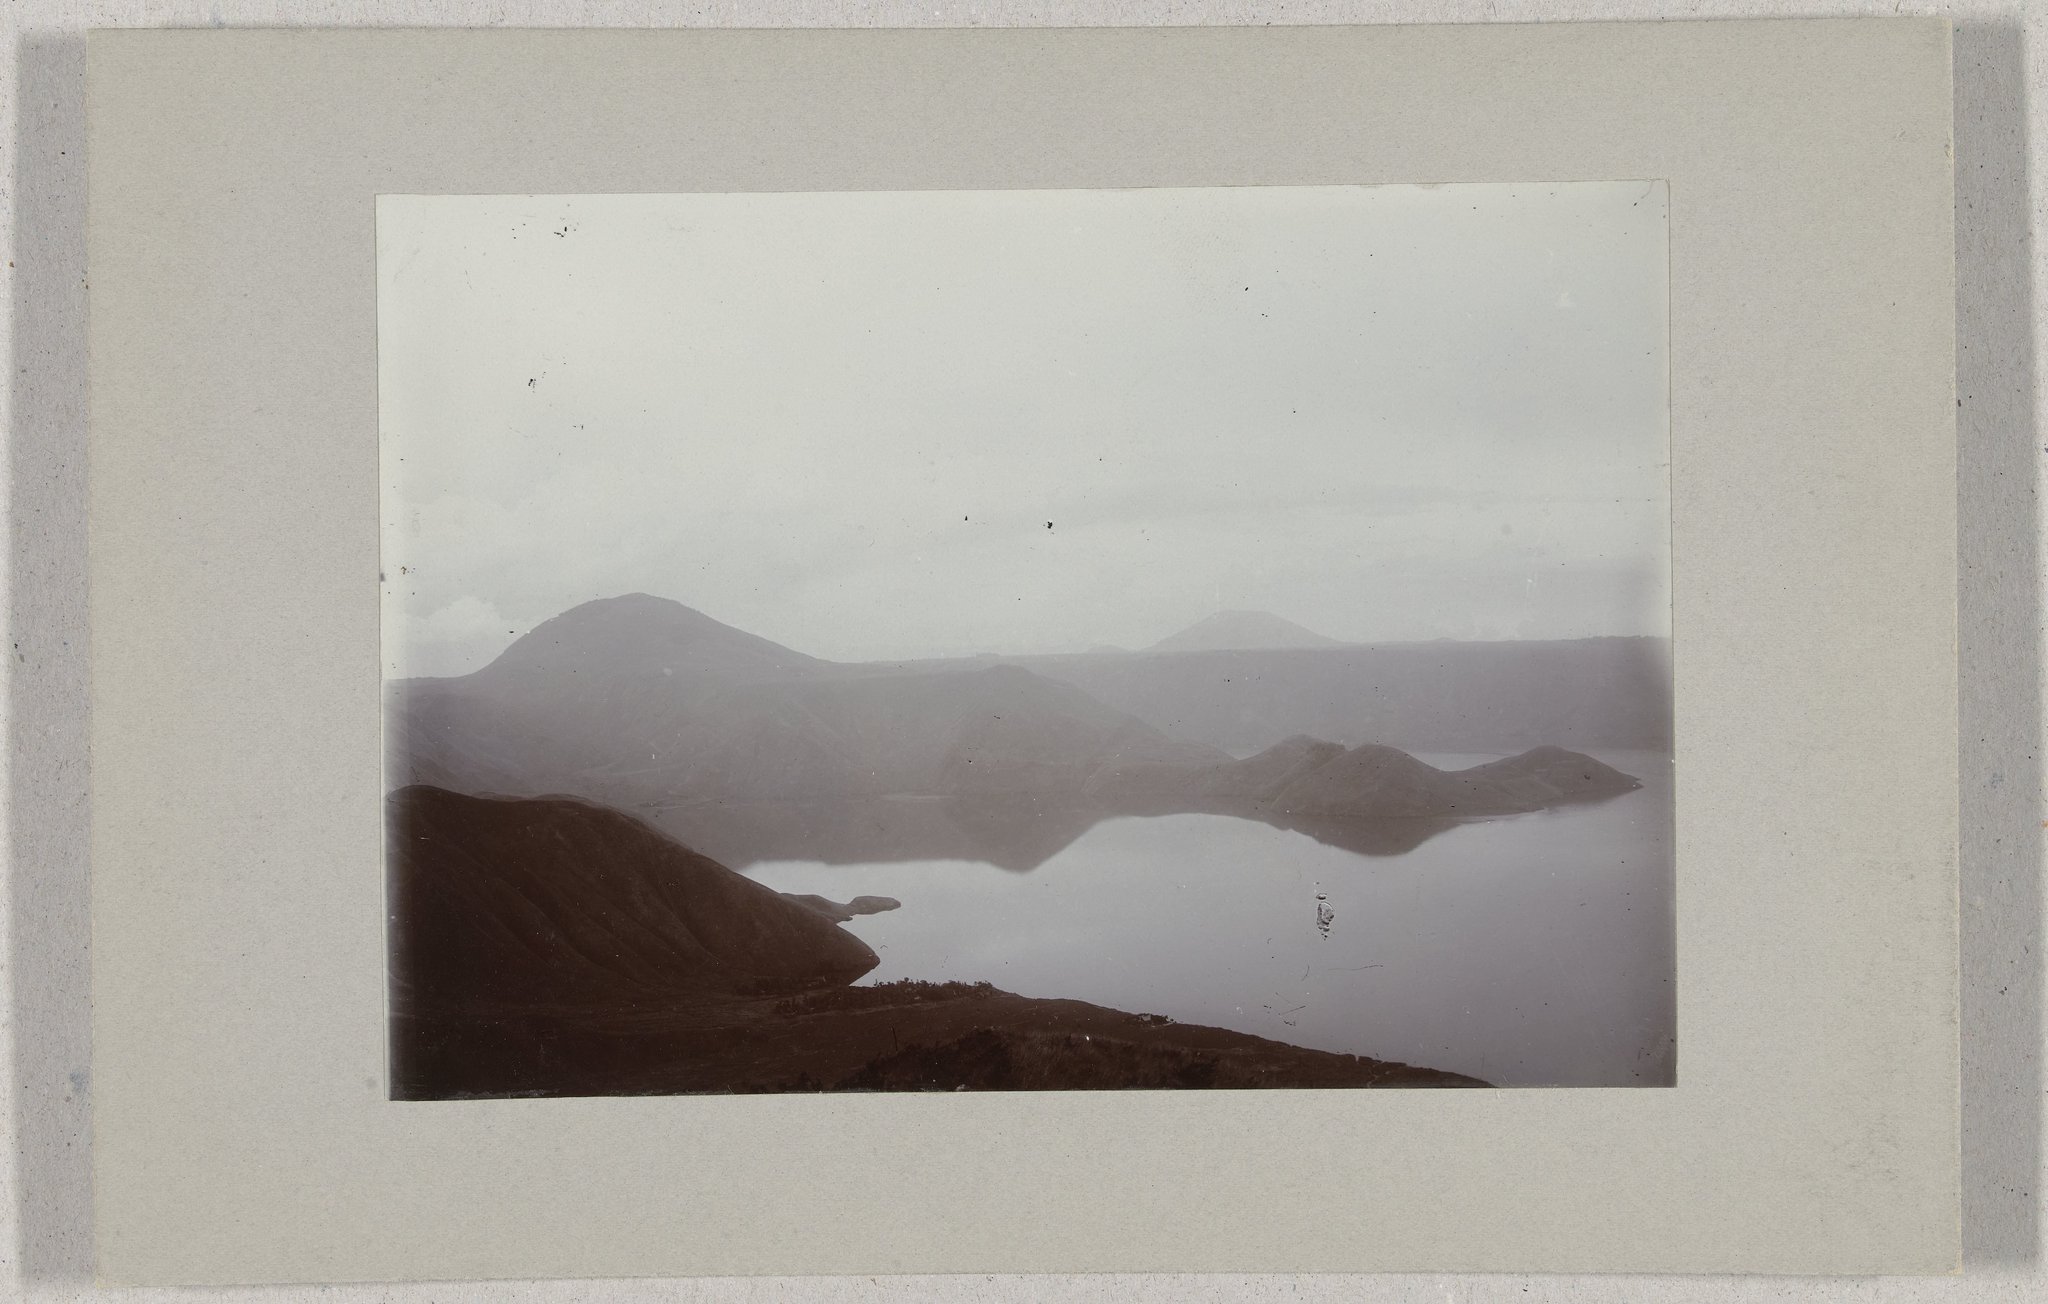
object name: photograph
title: 9a Toba-meer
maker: Anonymous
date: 1895-1915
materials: cardboard, paper, photographic support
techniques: gelatin silver print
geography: sumatra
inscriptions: annotation: ‘9a Toba-meer’